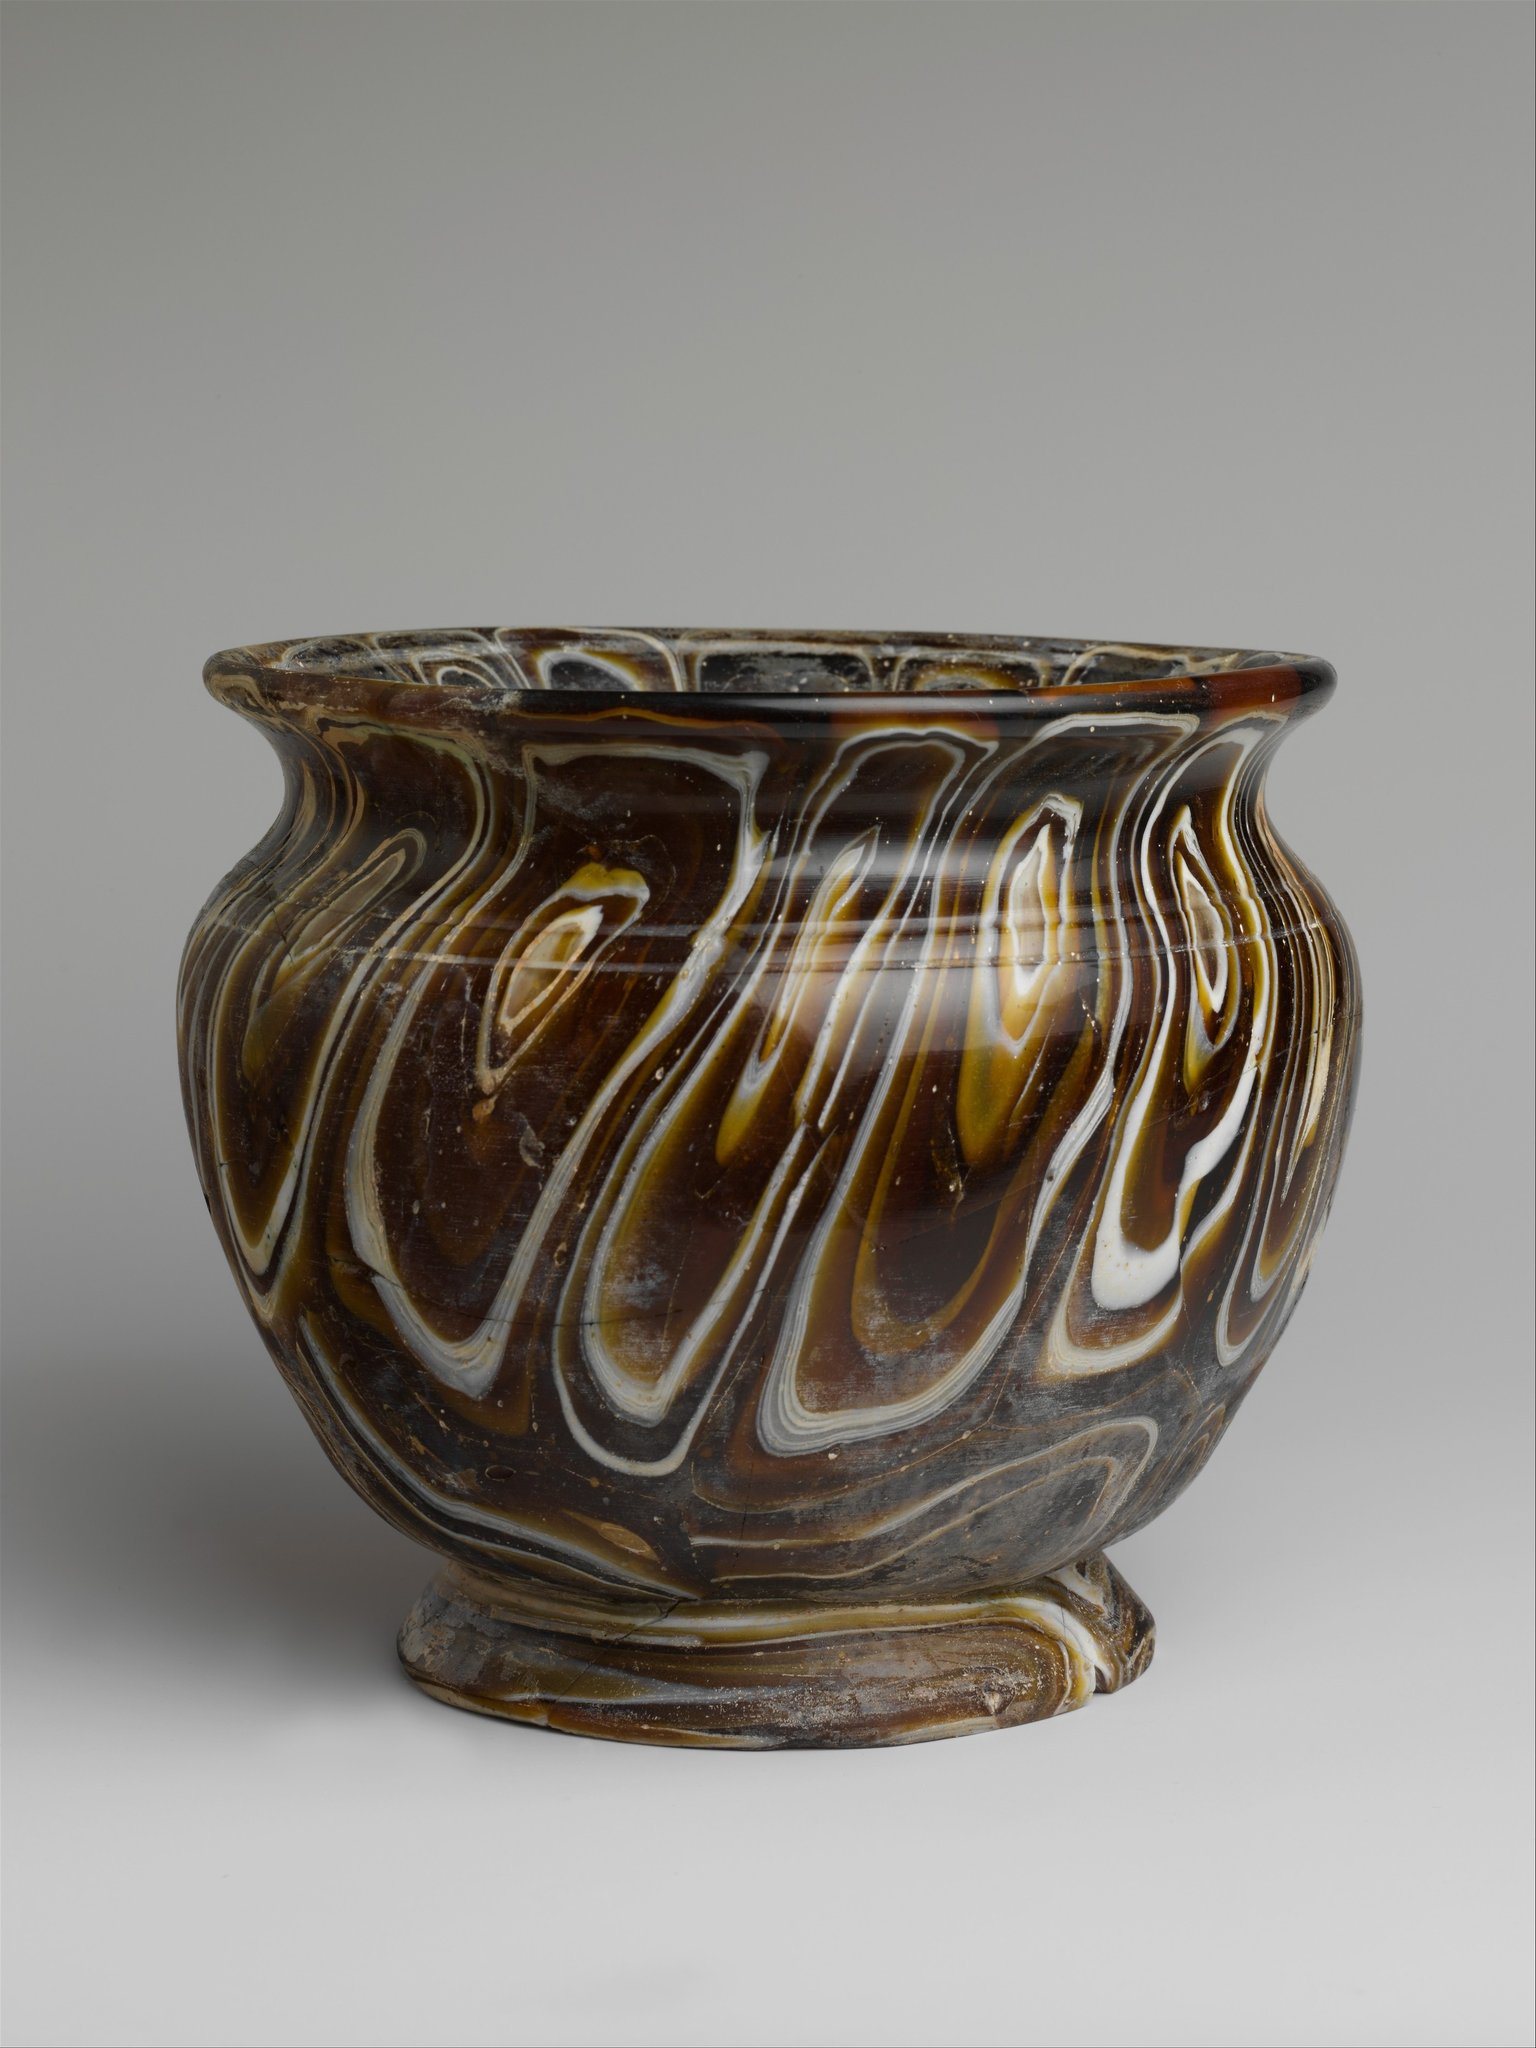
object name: jar, mosaic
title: Glass mosaic jar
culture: greek, eastern mediterranean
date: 200-68 BCE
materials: glass